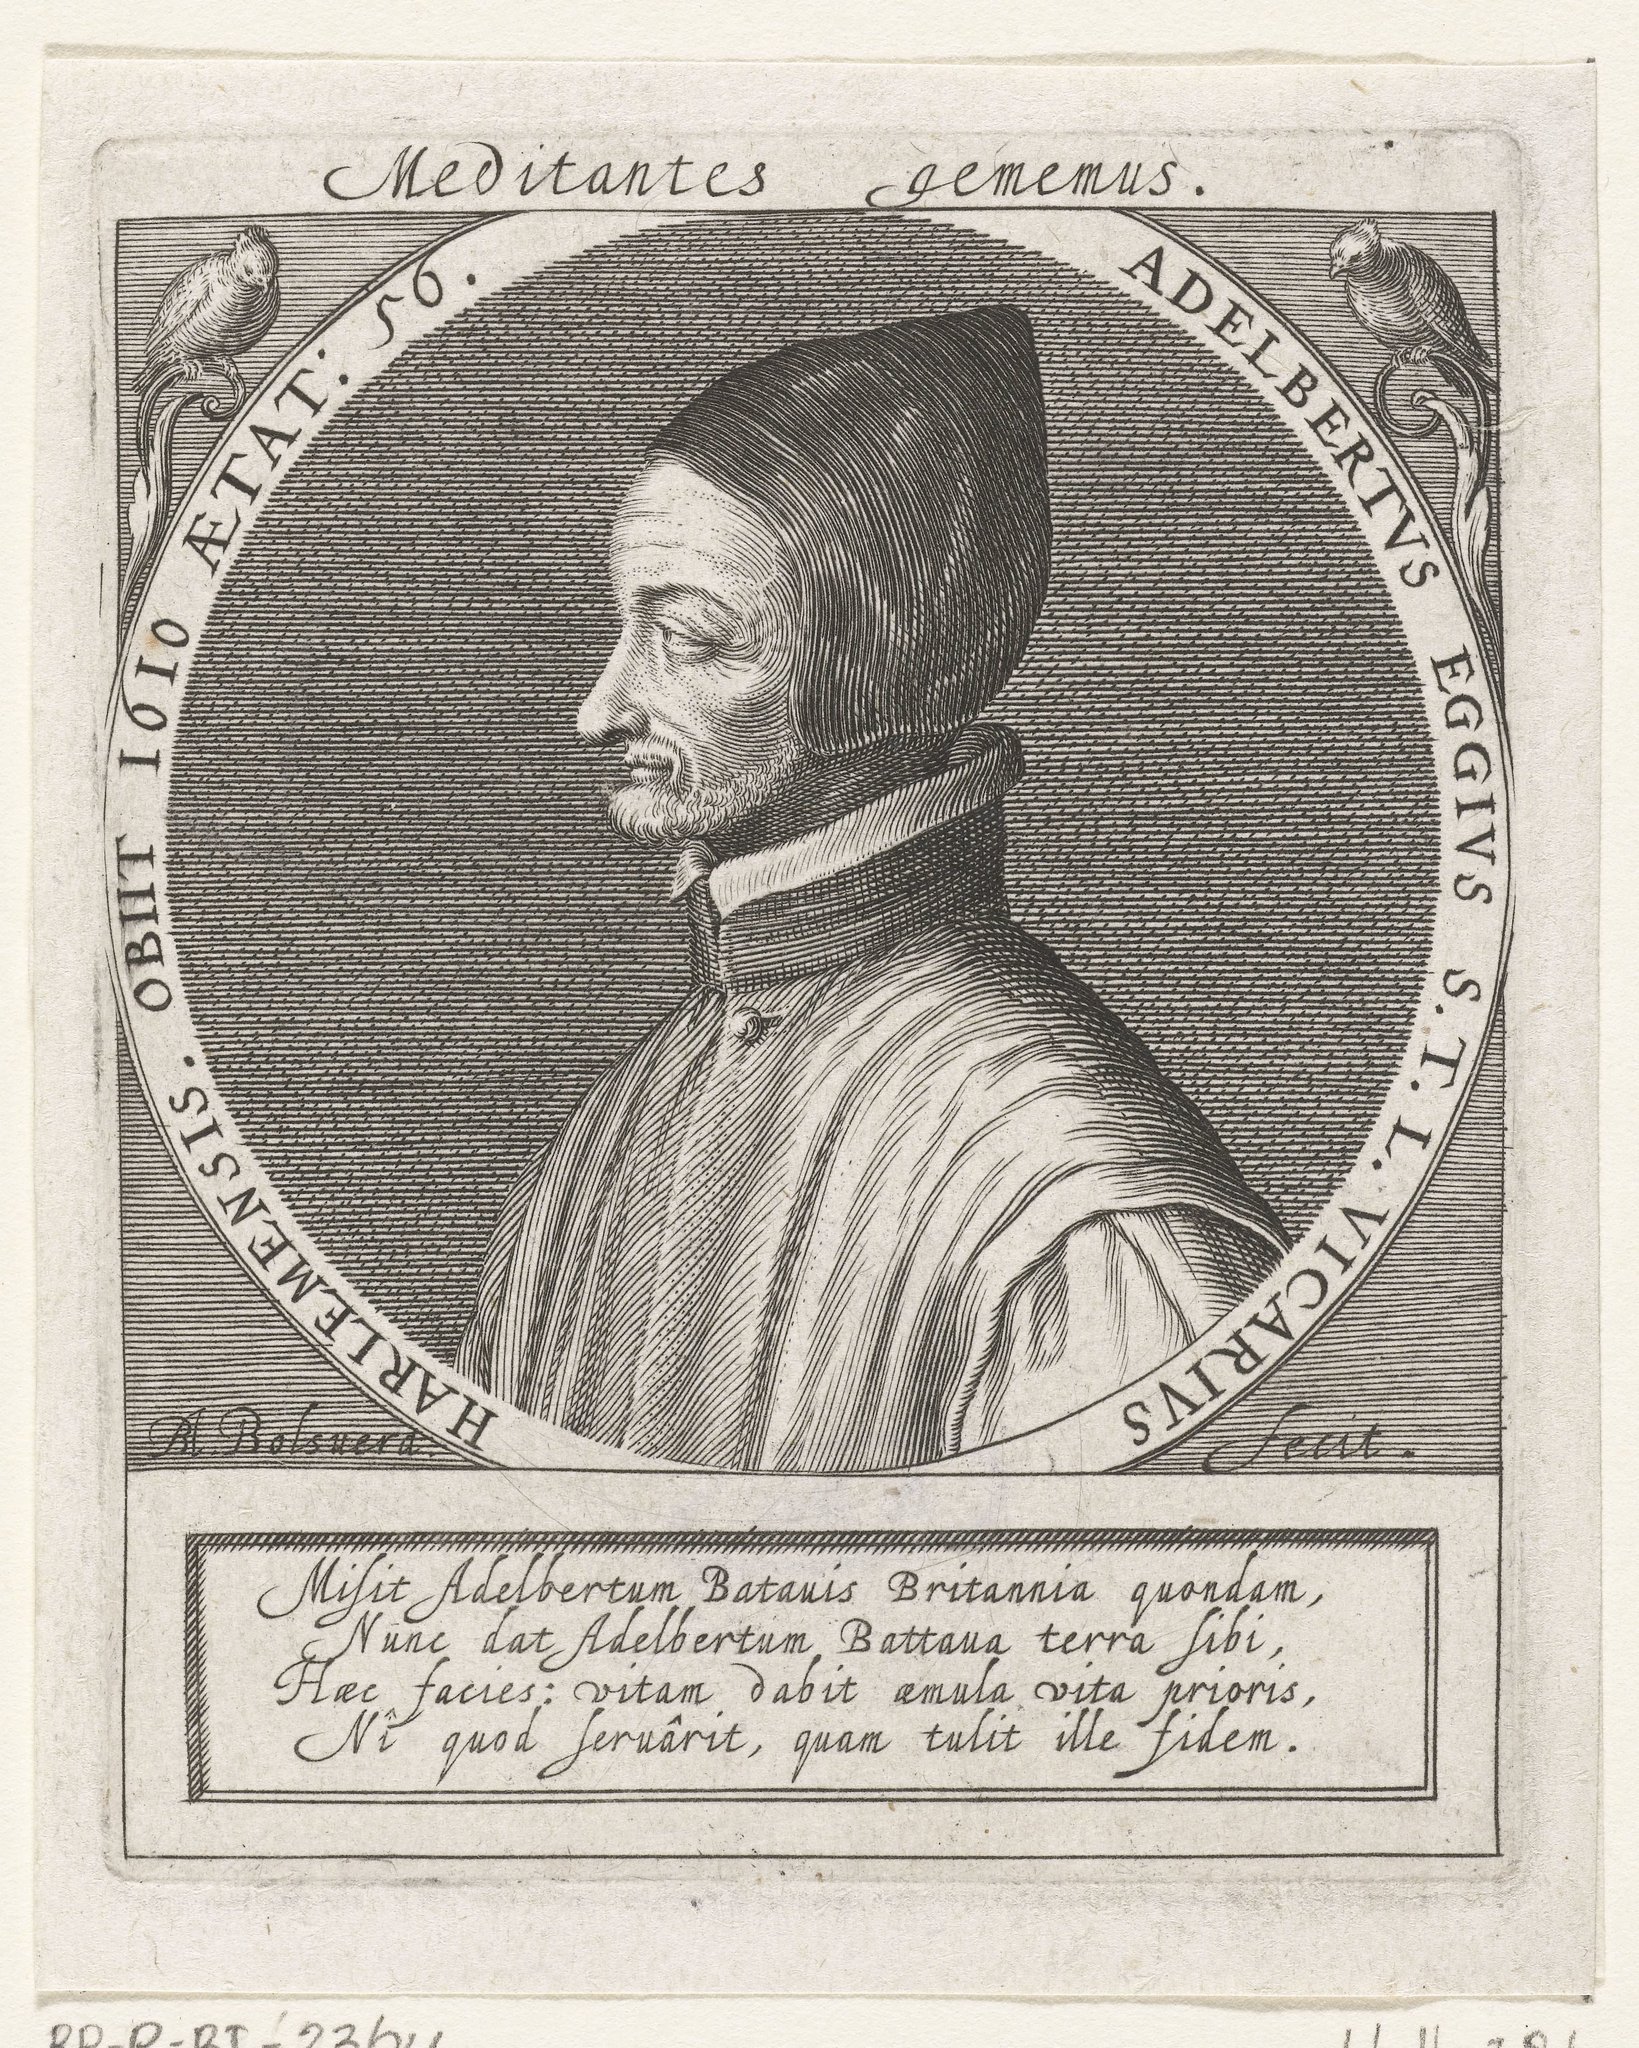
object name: print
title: Portret van vicaris Adelbertus Eggius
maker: boëtius adamsz. bolswert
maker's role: print maker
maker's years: 1580-1633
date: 1590-1633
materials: paper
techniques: engraving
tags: priest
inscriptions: inscription: ‘Milit Adelbertum Batauis ... tulit ille fidem’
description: Portret van Adelbertus Eggius, vicaris te Haarlem en overleden op 56-jarige leeftijd aldus opschrift in ronde omlijisting. Latijns vers in rechthoekig kader. Boven het portret staat een zinspreuk van de man: Meditantes gememus.